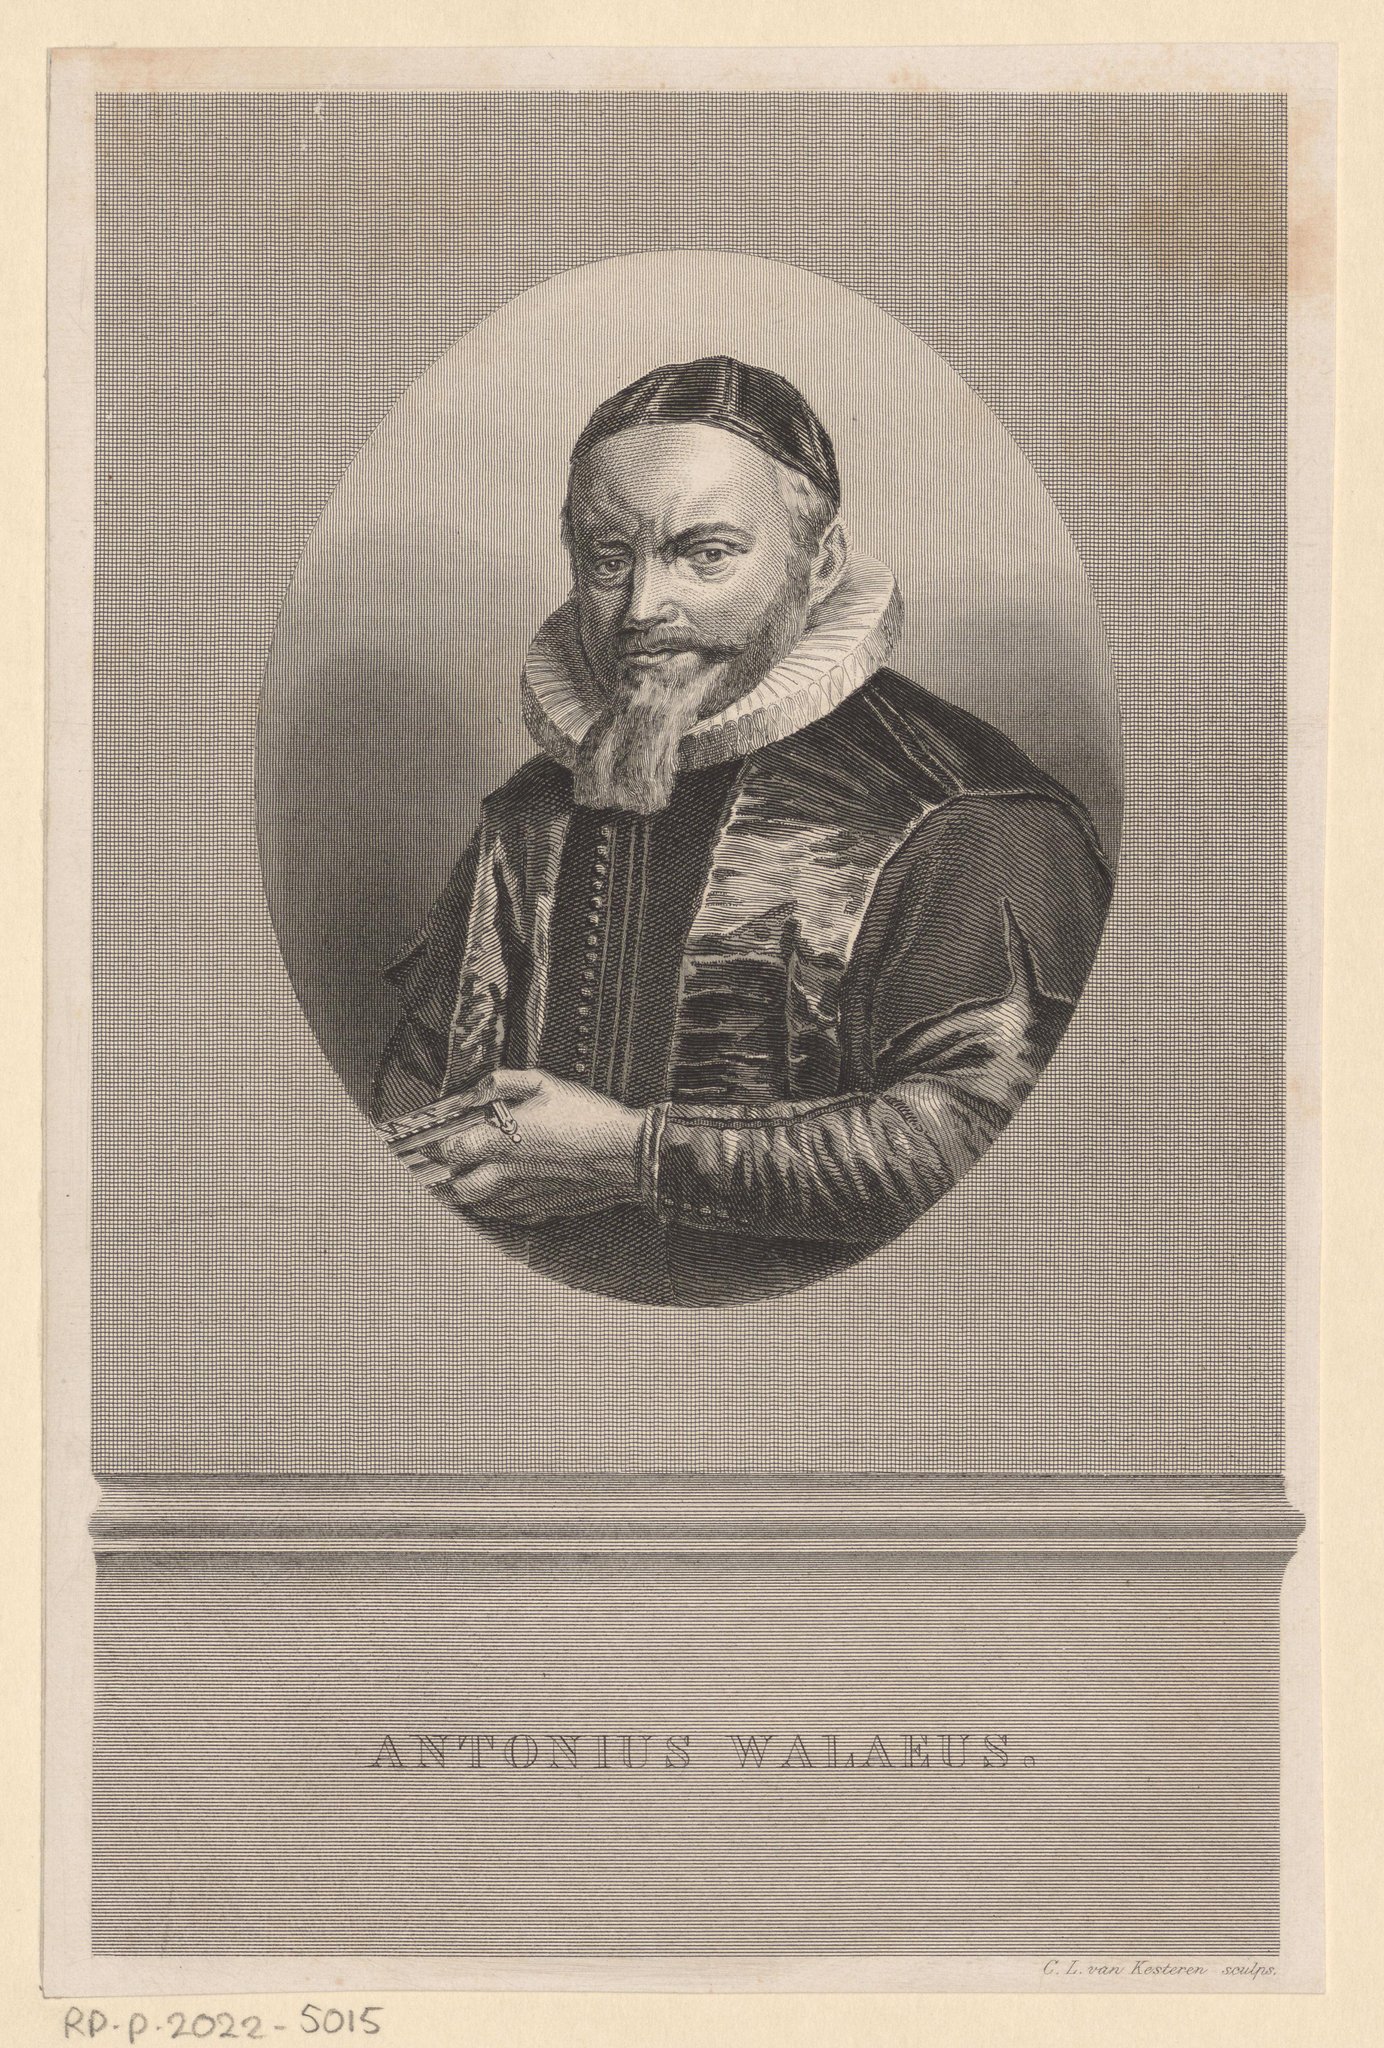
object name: print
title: Portret van Anthony de Wale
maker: christiaan lodewijk van kesteren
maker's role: print maker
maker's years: 1832-1897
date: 1860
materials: paper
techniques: engraving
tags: ghent, theologian, historical persons, professor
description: Prent met tekst op verso gebruikt in: Arend, Johannes Pieter, Otto van Rees. Algemeene geschiedenis des vaderlands (...). Amsterdam: Schleijer en Zoon, 1860, dl. 3.